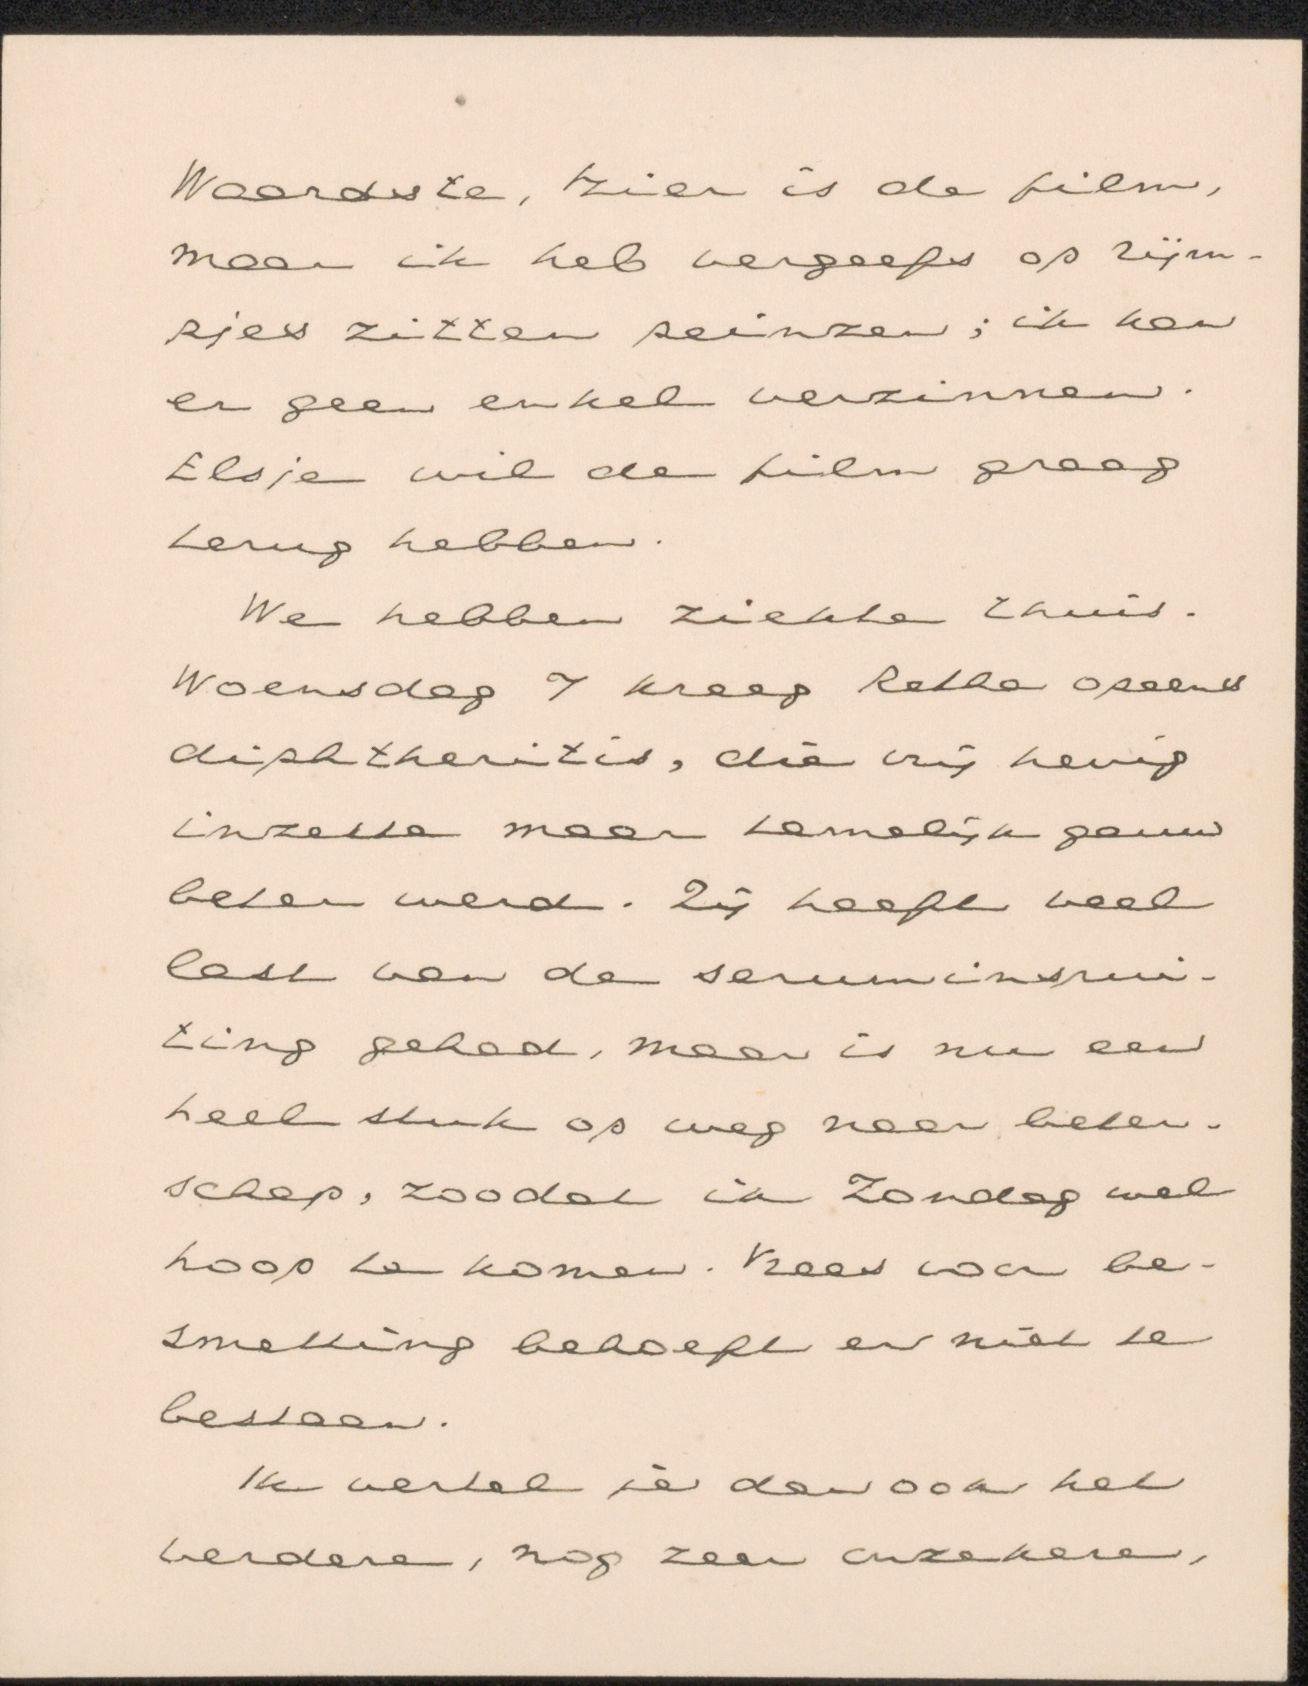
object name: letter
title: Brief aan Jan Veth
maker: johan huizinga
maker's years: 1872-1945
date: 1921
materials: ink, paper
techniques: pen, writing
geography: leiden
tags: dordrecht, painter, print maker, draughtsman, designer, jan veth, family life, diseases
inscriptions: collector's mark: ‘RPK’